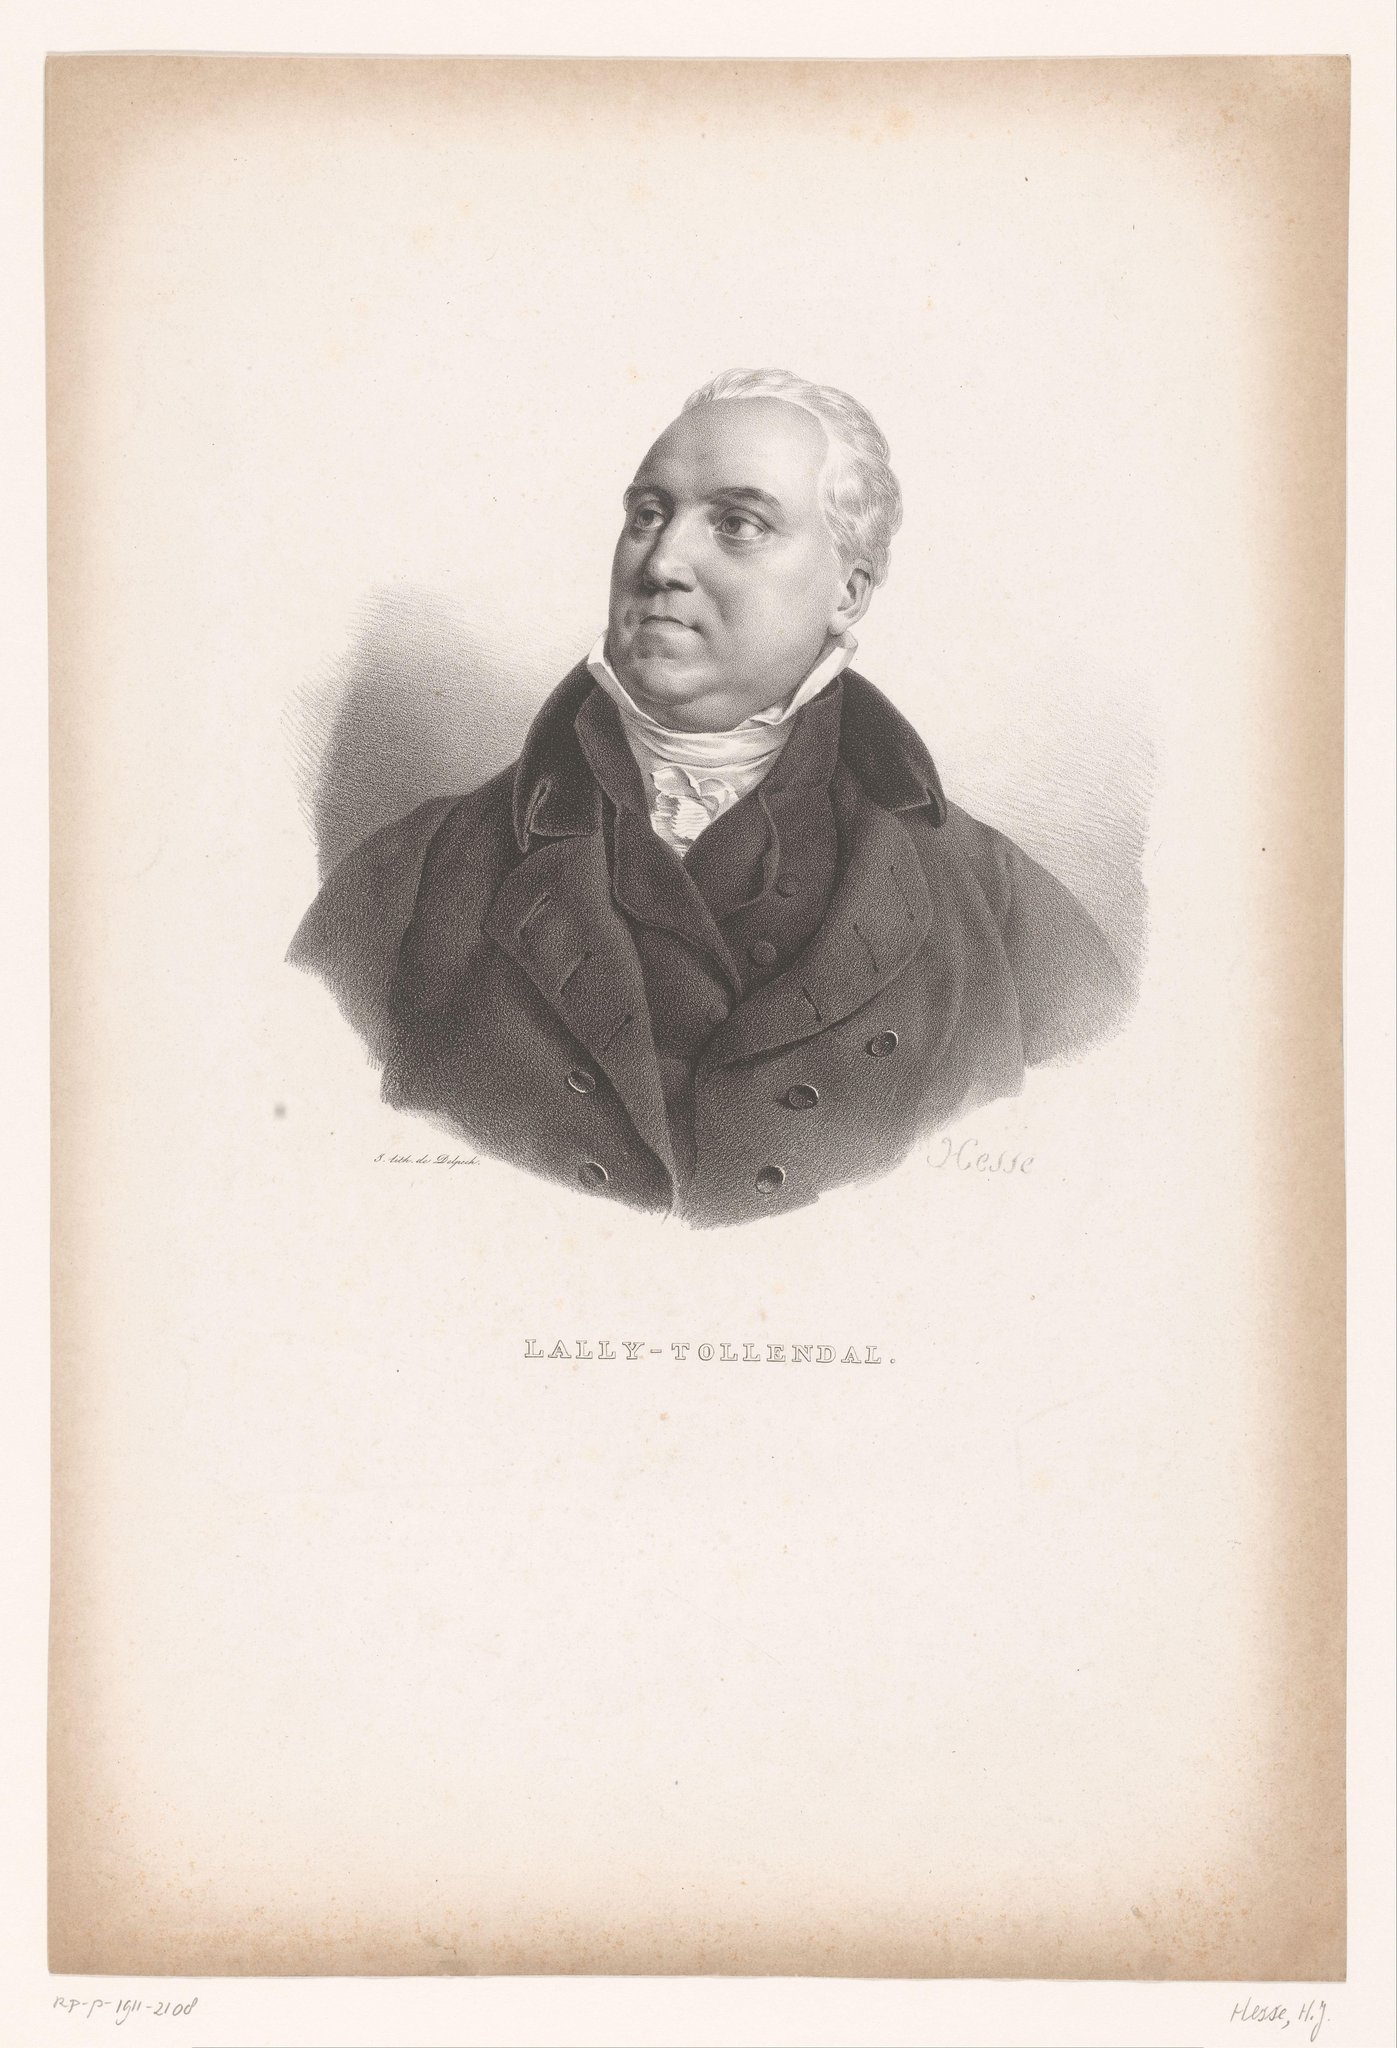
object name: print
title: Lally-Tollendal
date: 1823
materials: paper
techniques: lithograph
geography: paris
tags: paris, politician, gérard de lally-tollendal, historical persons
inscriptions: collector's mark: Lugt 2228a